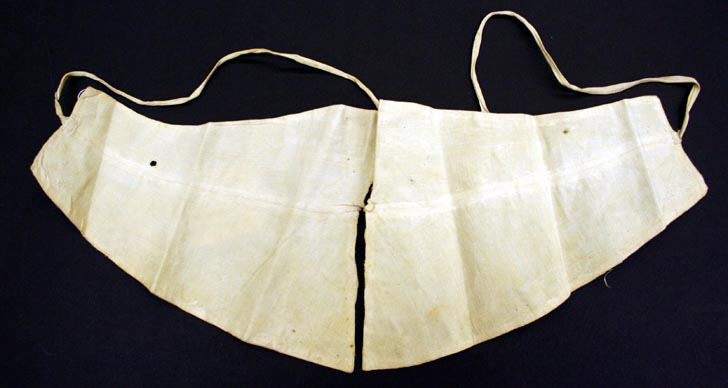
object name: collar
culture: french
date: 1825-1850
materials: linen